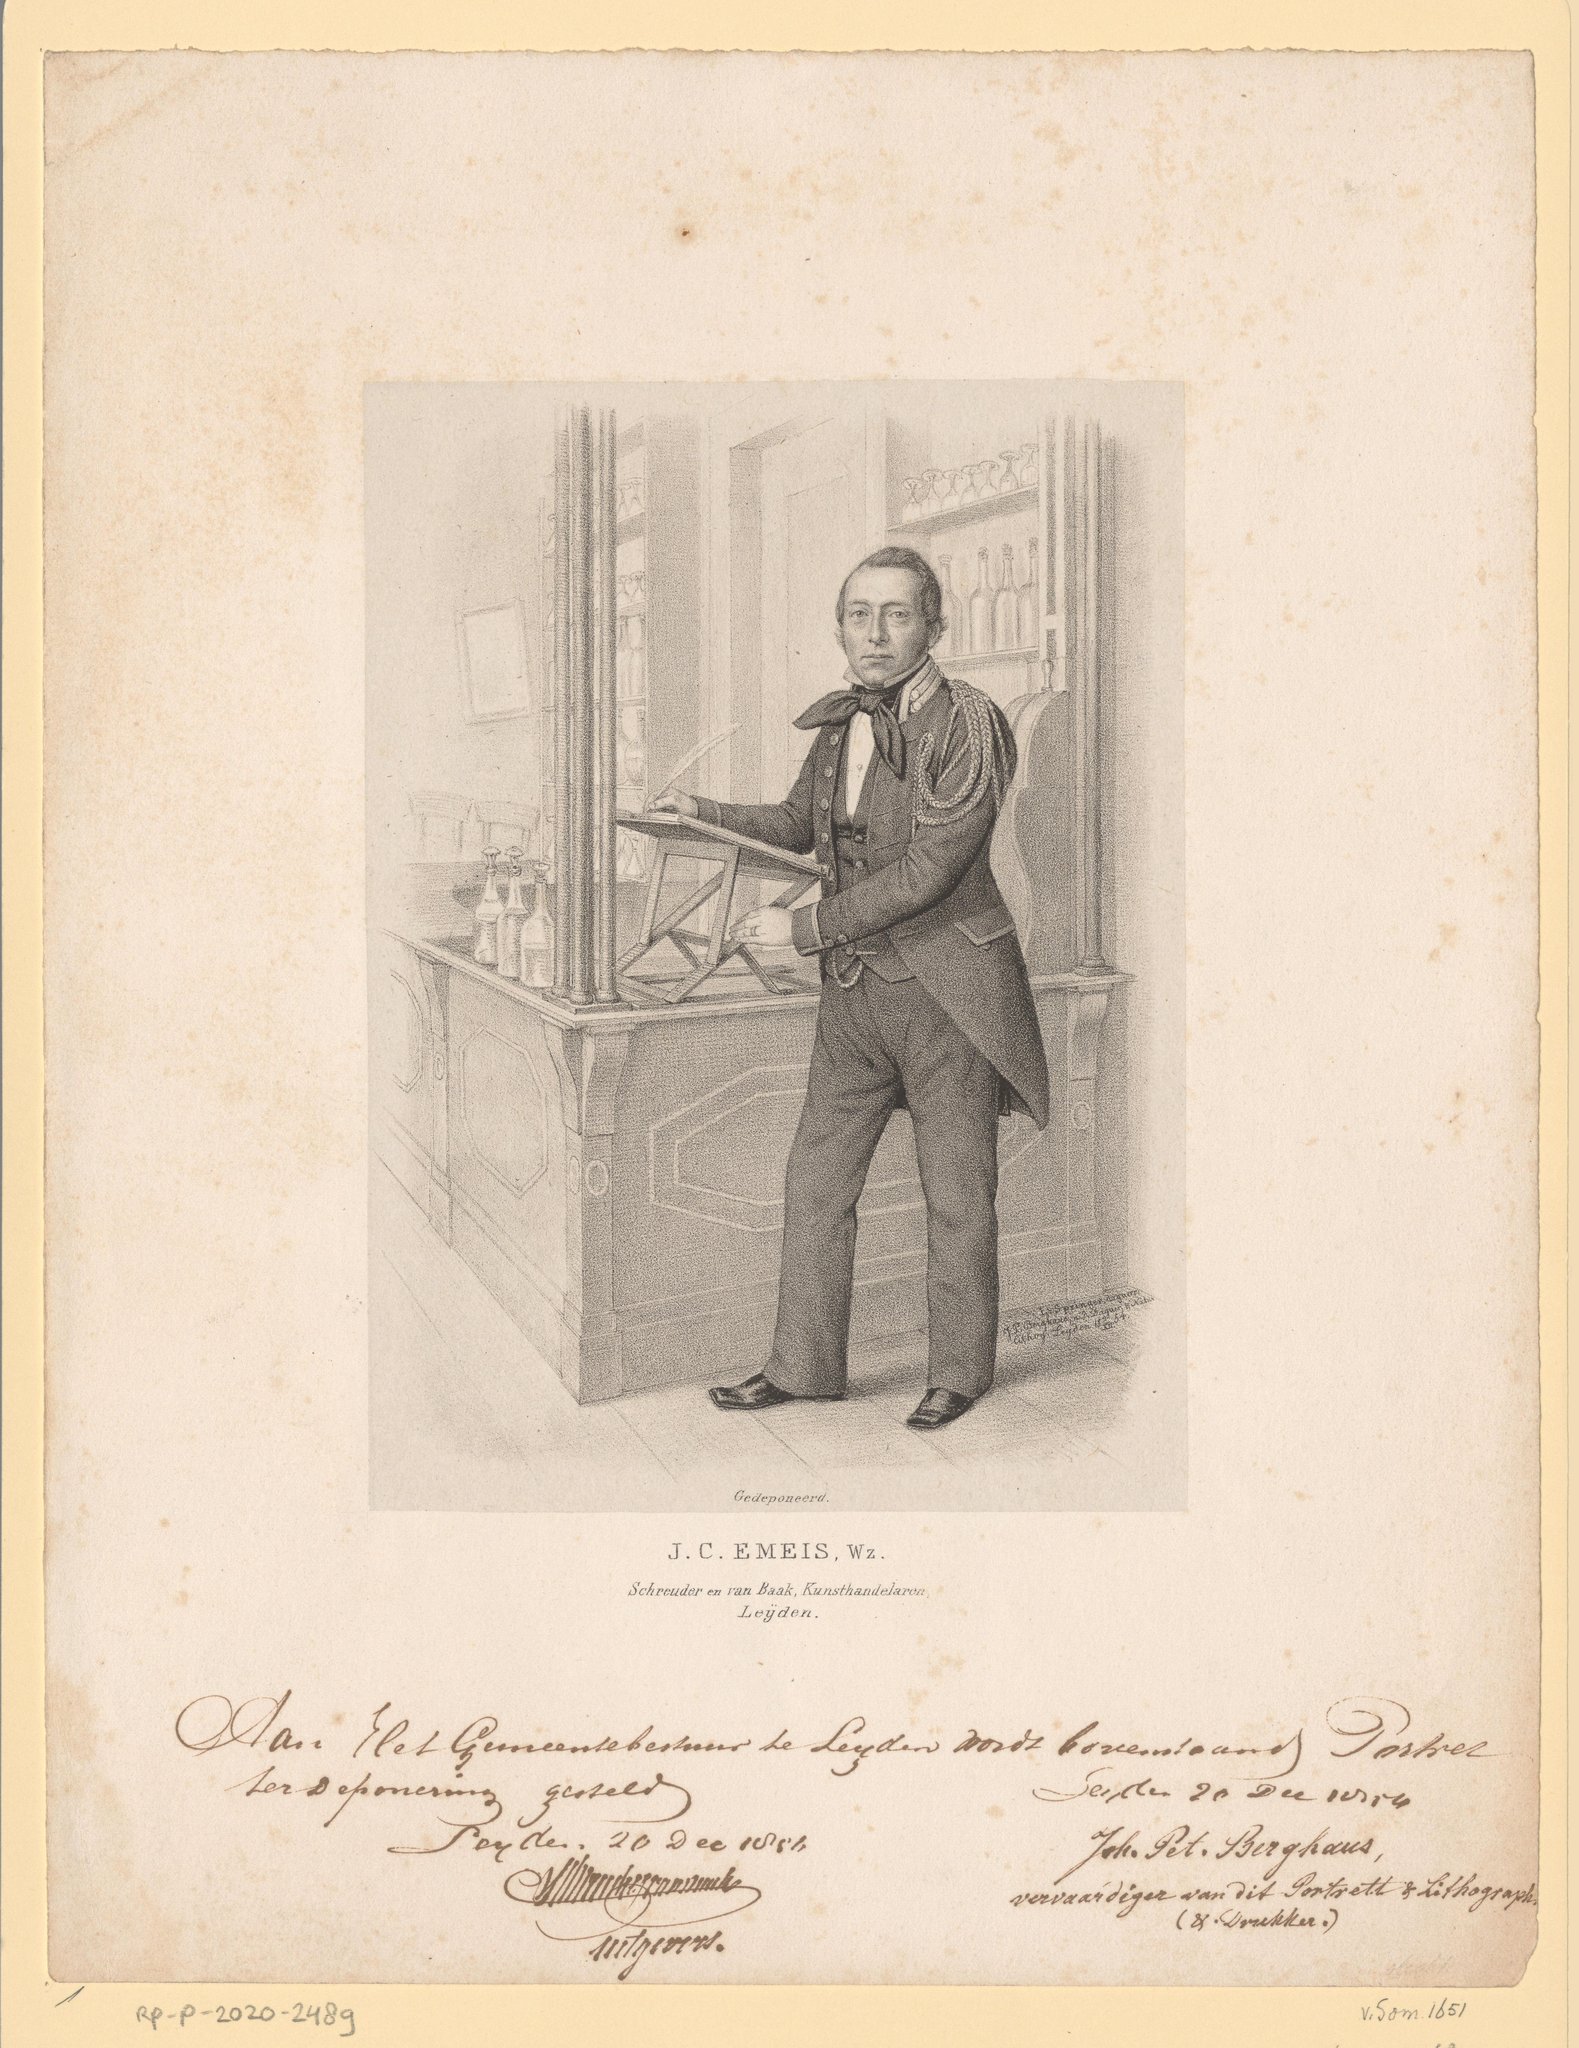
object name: print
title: Portret van Johannes Cornelis Emeis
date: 1854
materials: paper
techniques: lithograph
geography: leiden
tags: historical persons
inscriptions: : ‘Aan het Gemeentebestuur te Leyden wordt bovenstaand Portret/ ter deponering gesteld/ Leyden 20 Dec 1854/ Joh. Pet. Berghaus,/ vervaardiger van dit Portrett & Lithograph. (& drukker.)/ Leyden 20 Dec 1854/ uitgevers.’, : ‘Gedeponeerd.’